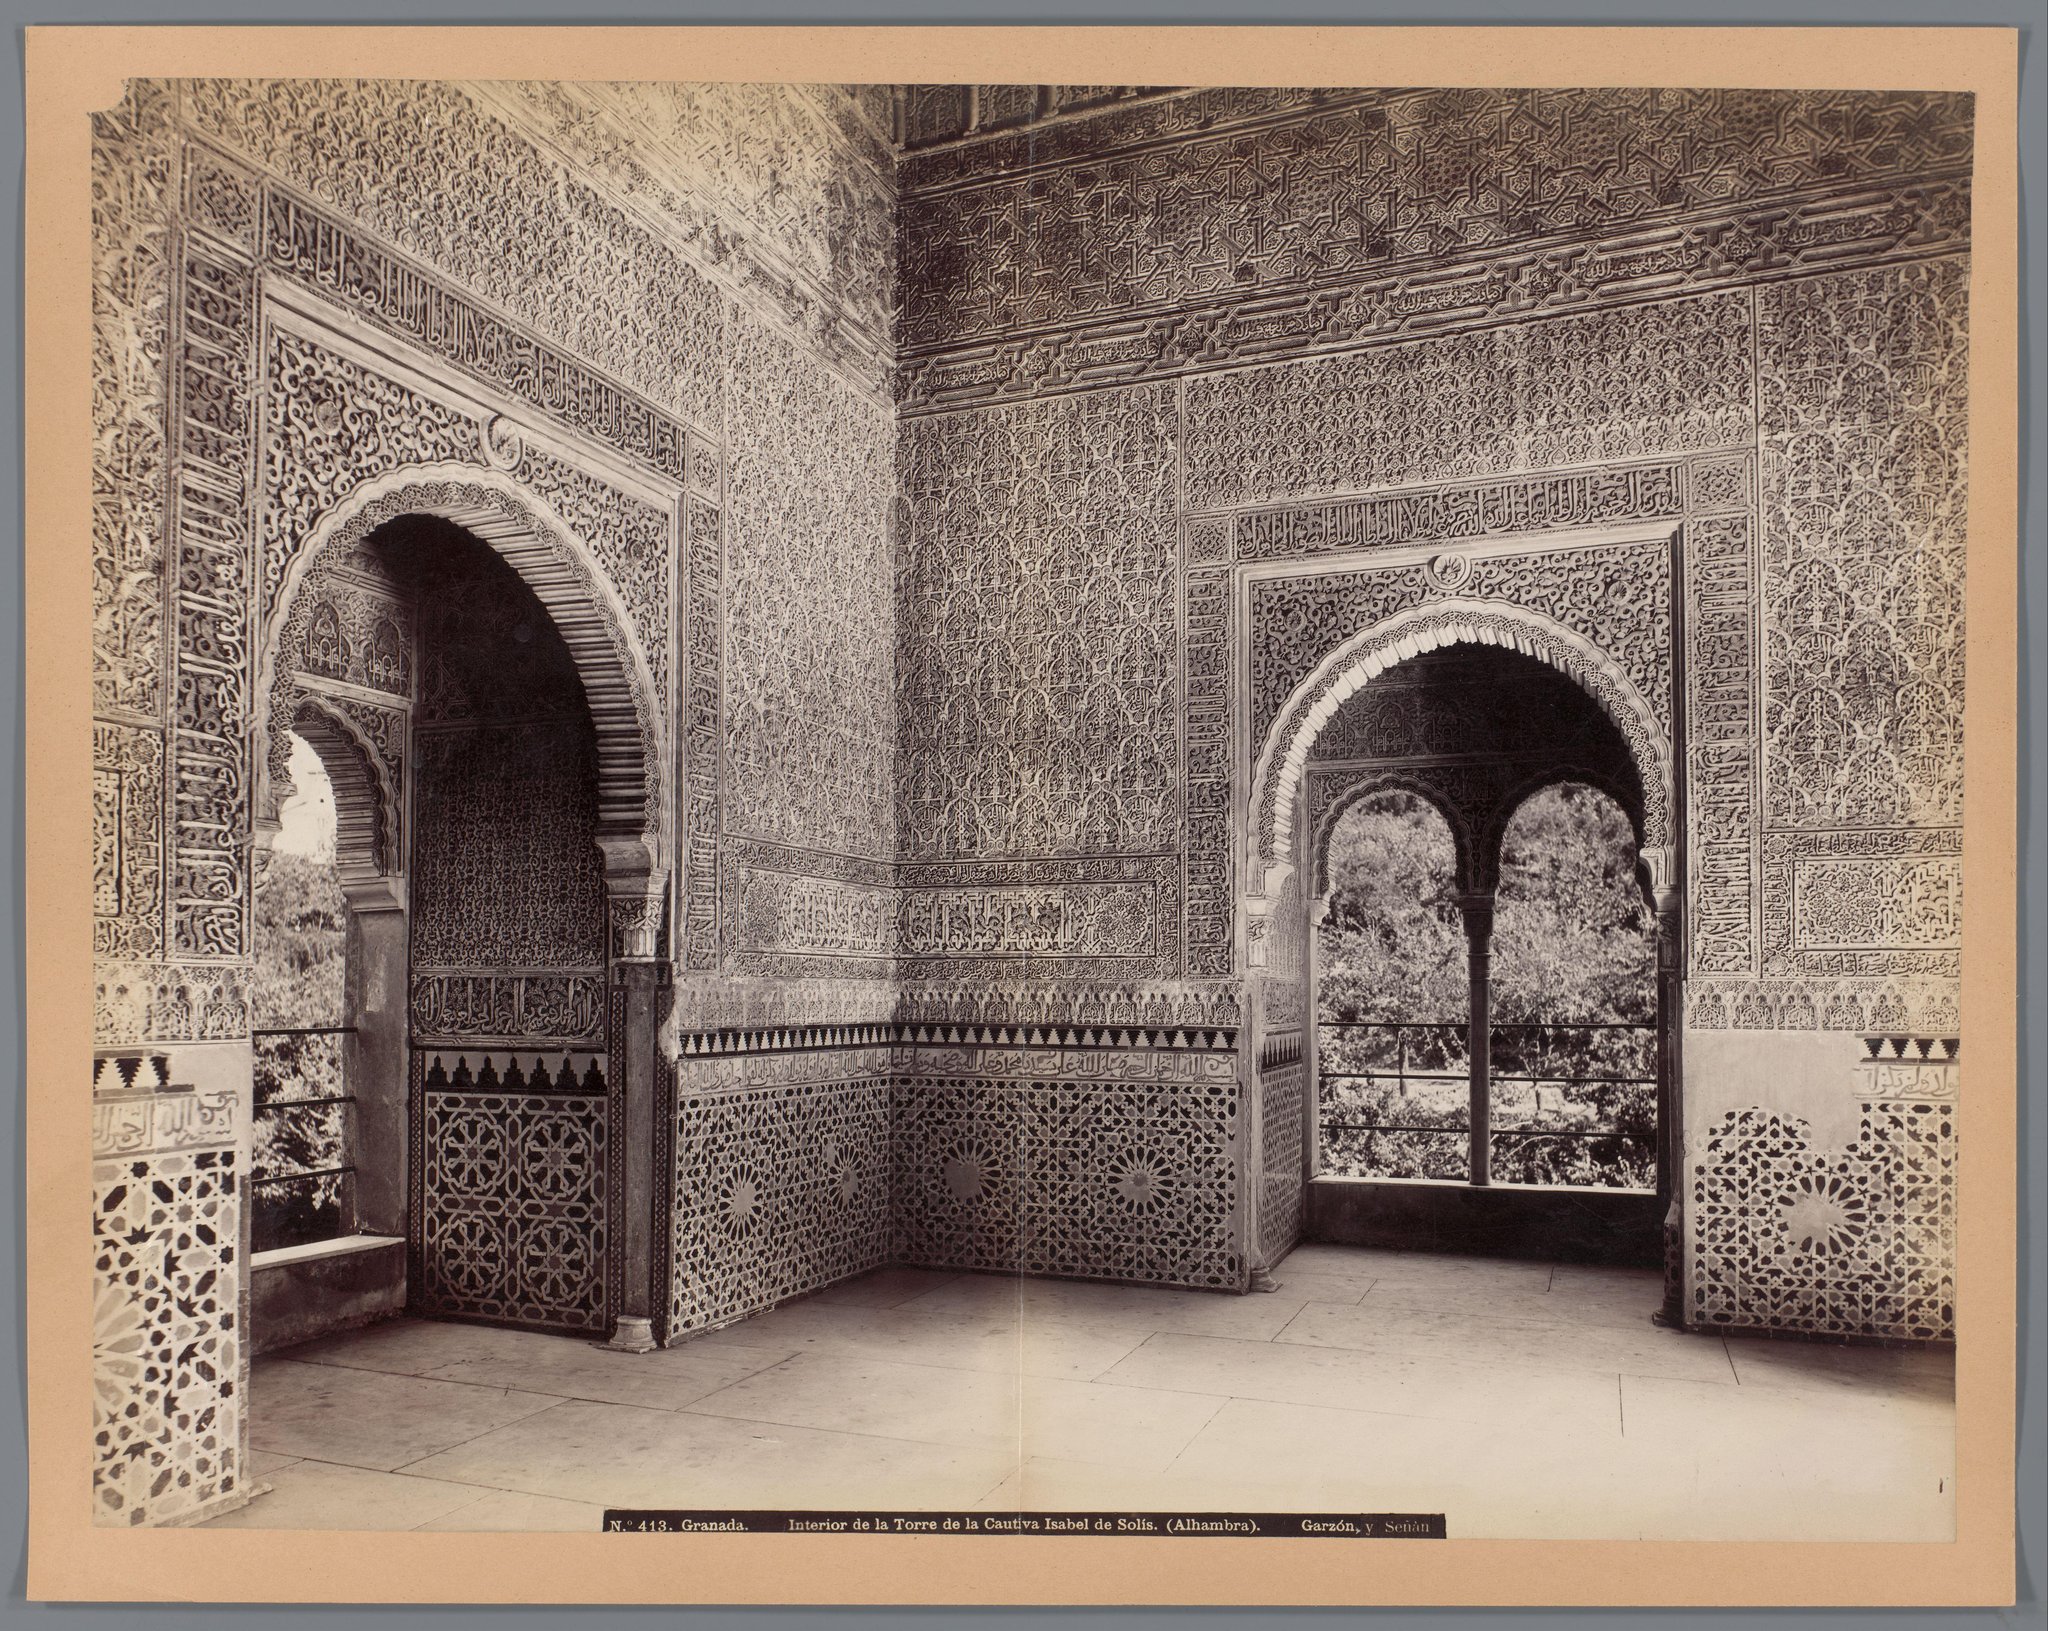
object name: photograph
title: Interieur van een zaal van het Alhambra te Granada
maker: rafael garzón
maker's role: publisher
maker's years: 1863-1923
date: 1870-1895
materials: cardboard, paper, photographic support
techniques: albumen print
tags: palace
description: Granada. Interior de la Torre de la Cautiva Isabel de Solis (Alhambra)